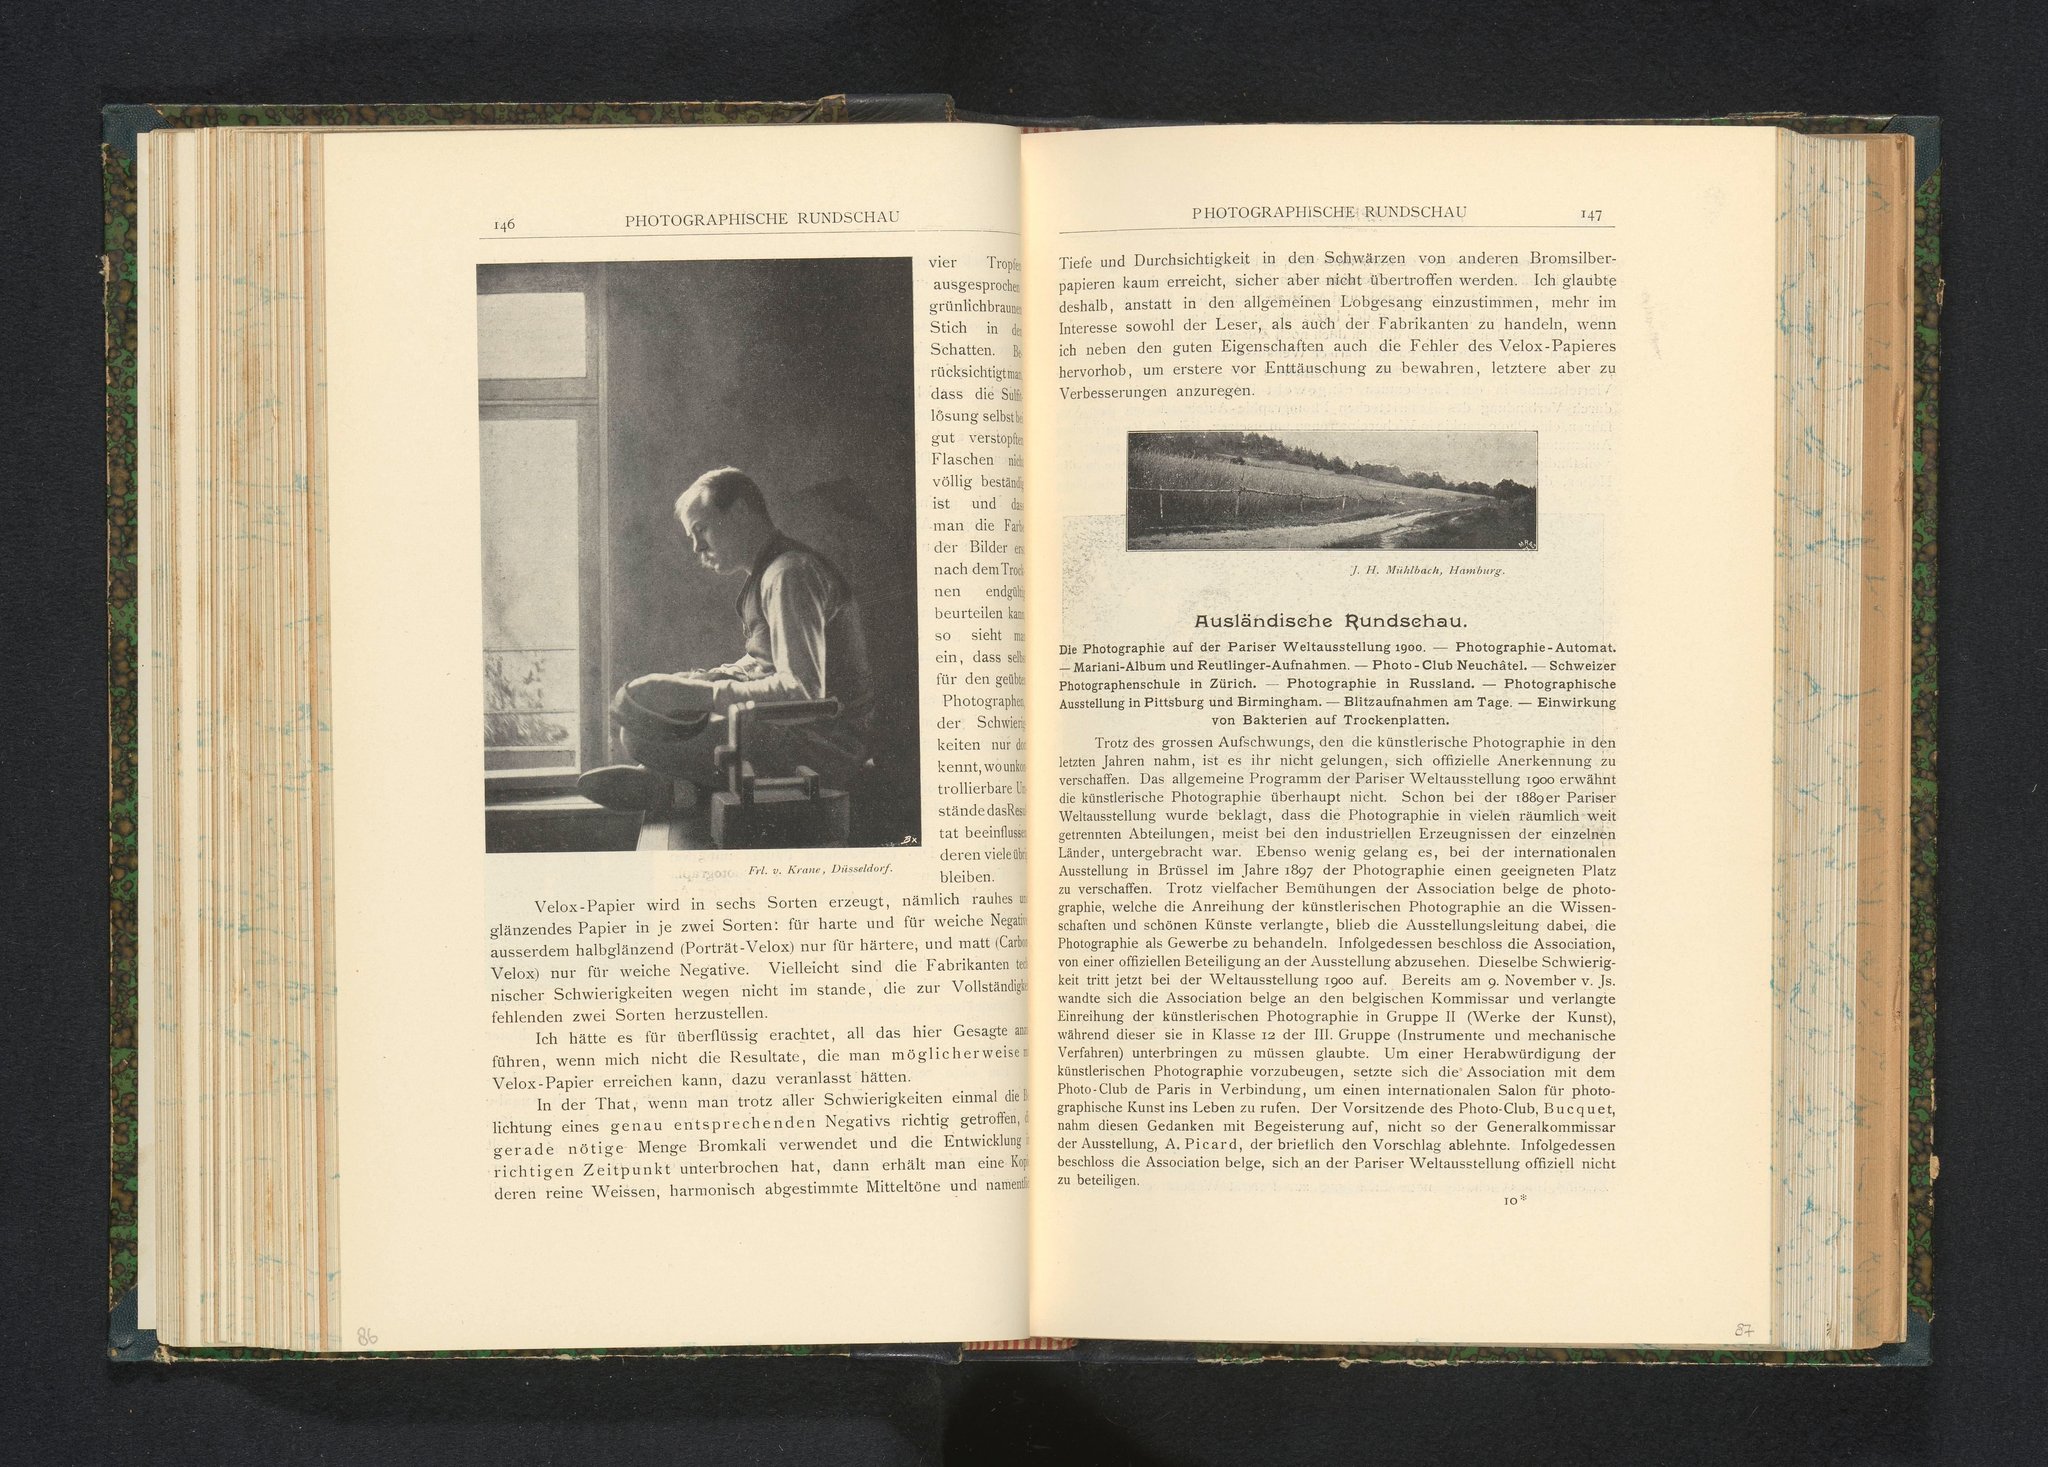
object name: page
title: Gezicht op een landweg naast een weiland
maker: j.h. mühlbach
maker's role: fotograaf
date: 1894-1899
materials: paper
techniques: autotype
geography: berlin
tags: meadow, pasture, road, path